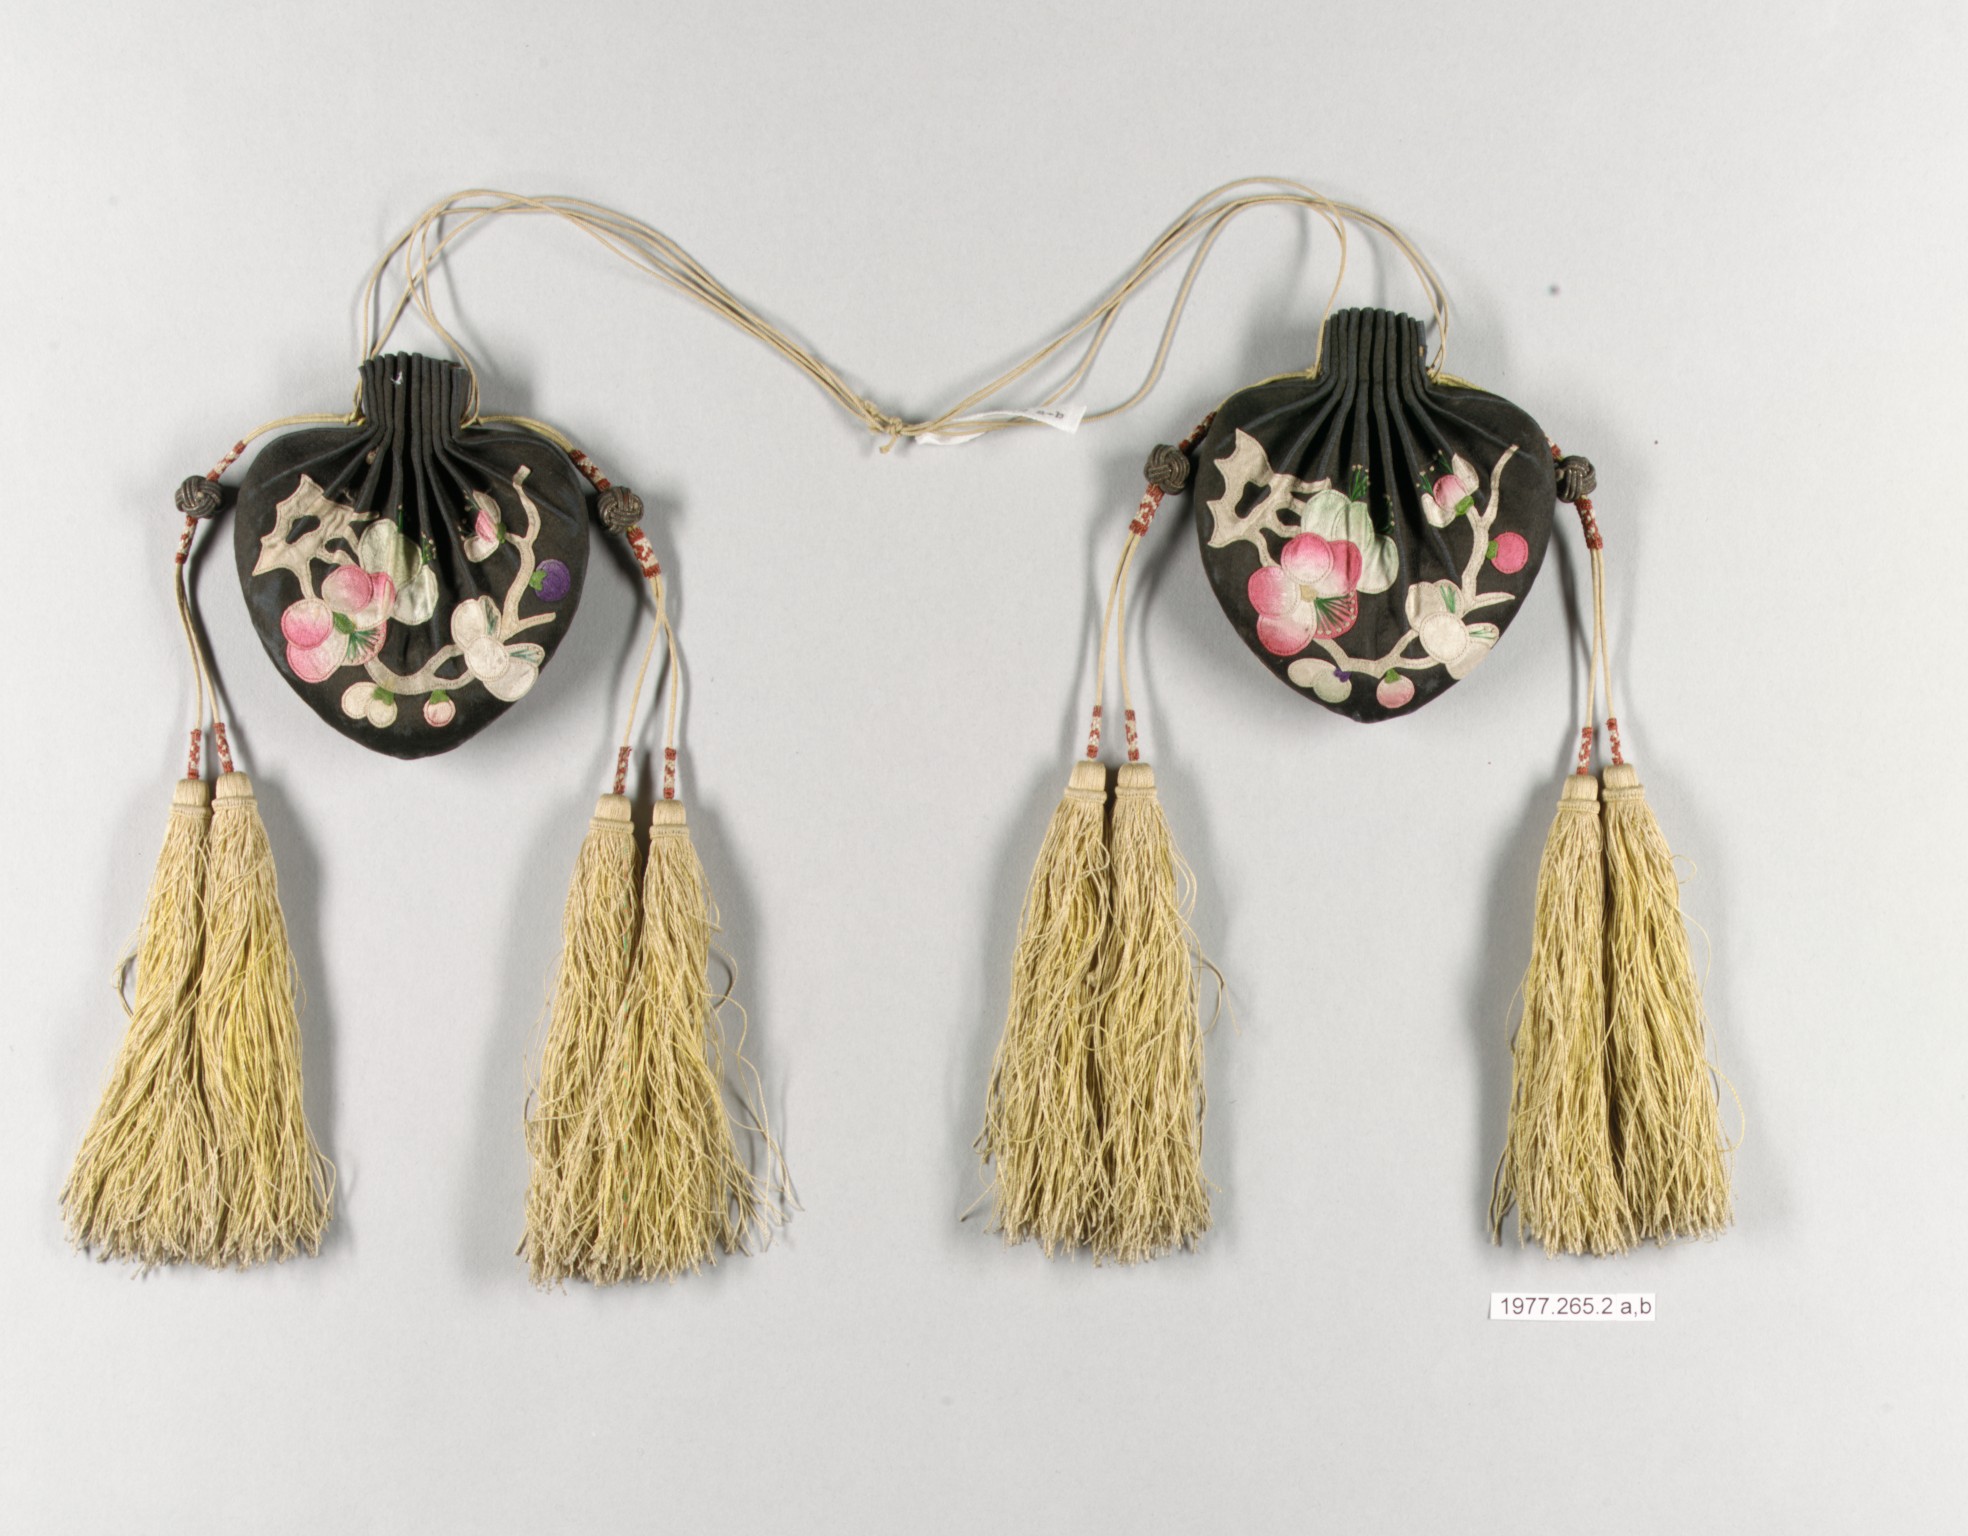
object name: bag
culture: chinese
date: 1867-1900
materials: silk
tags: flowers